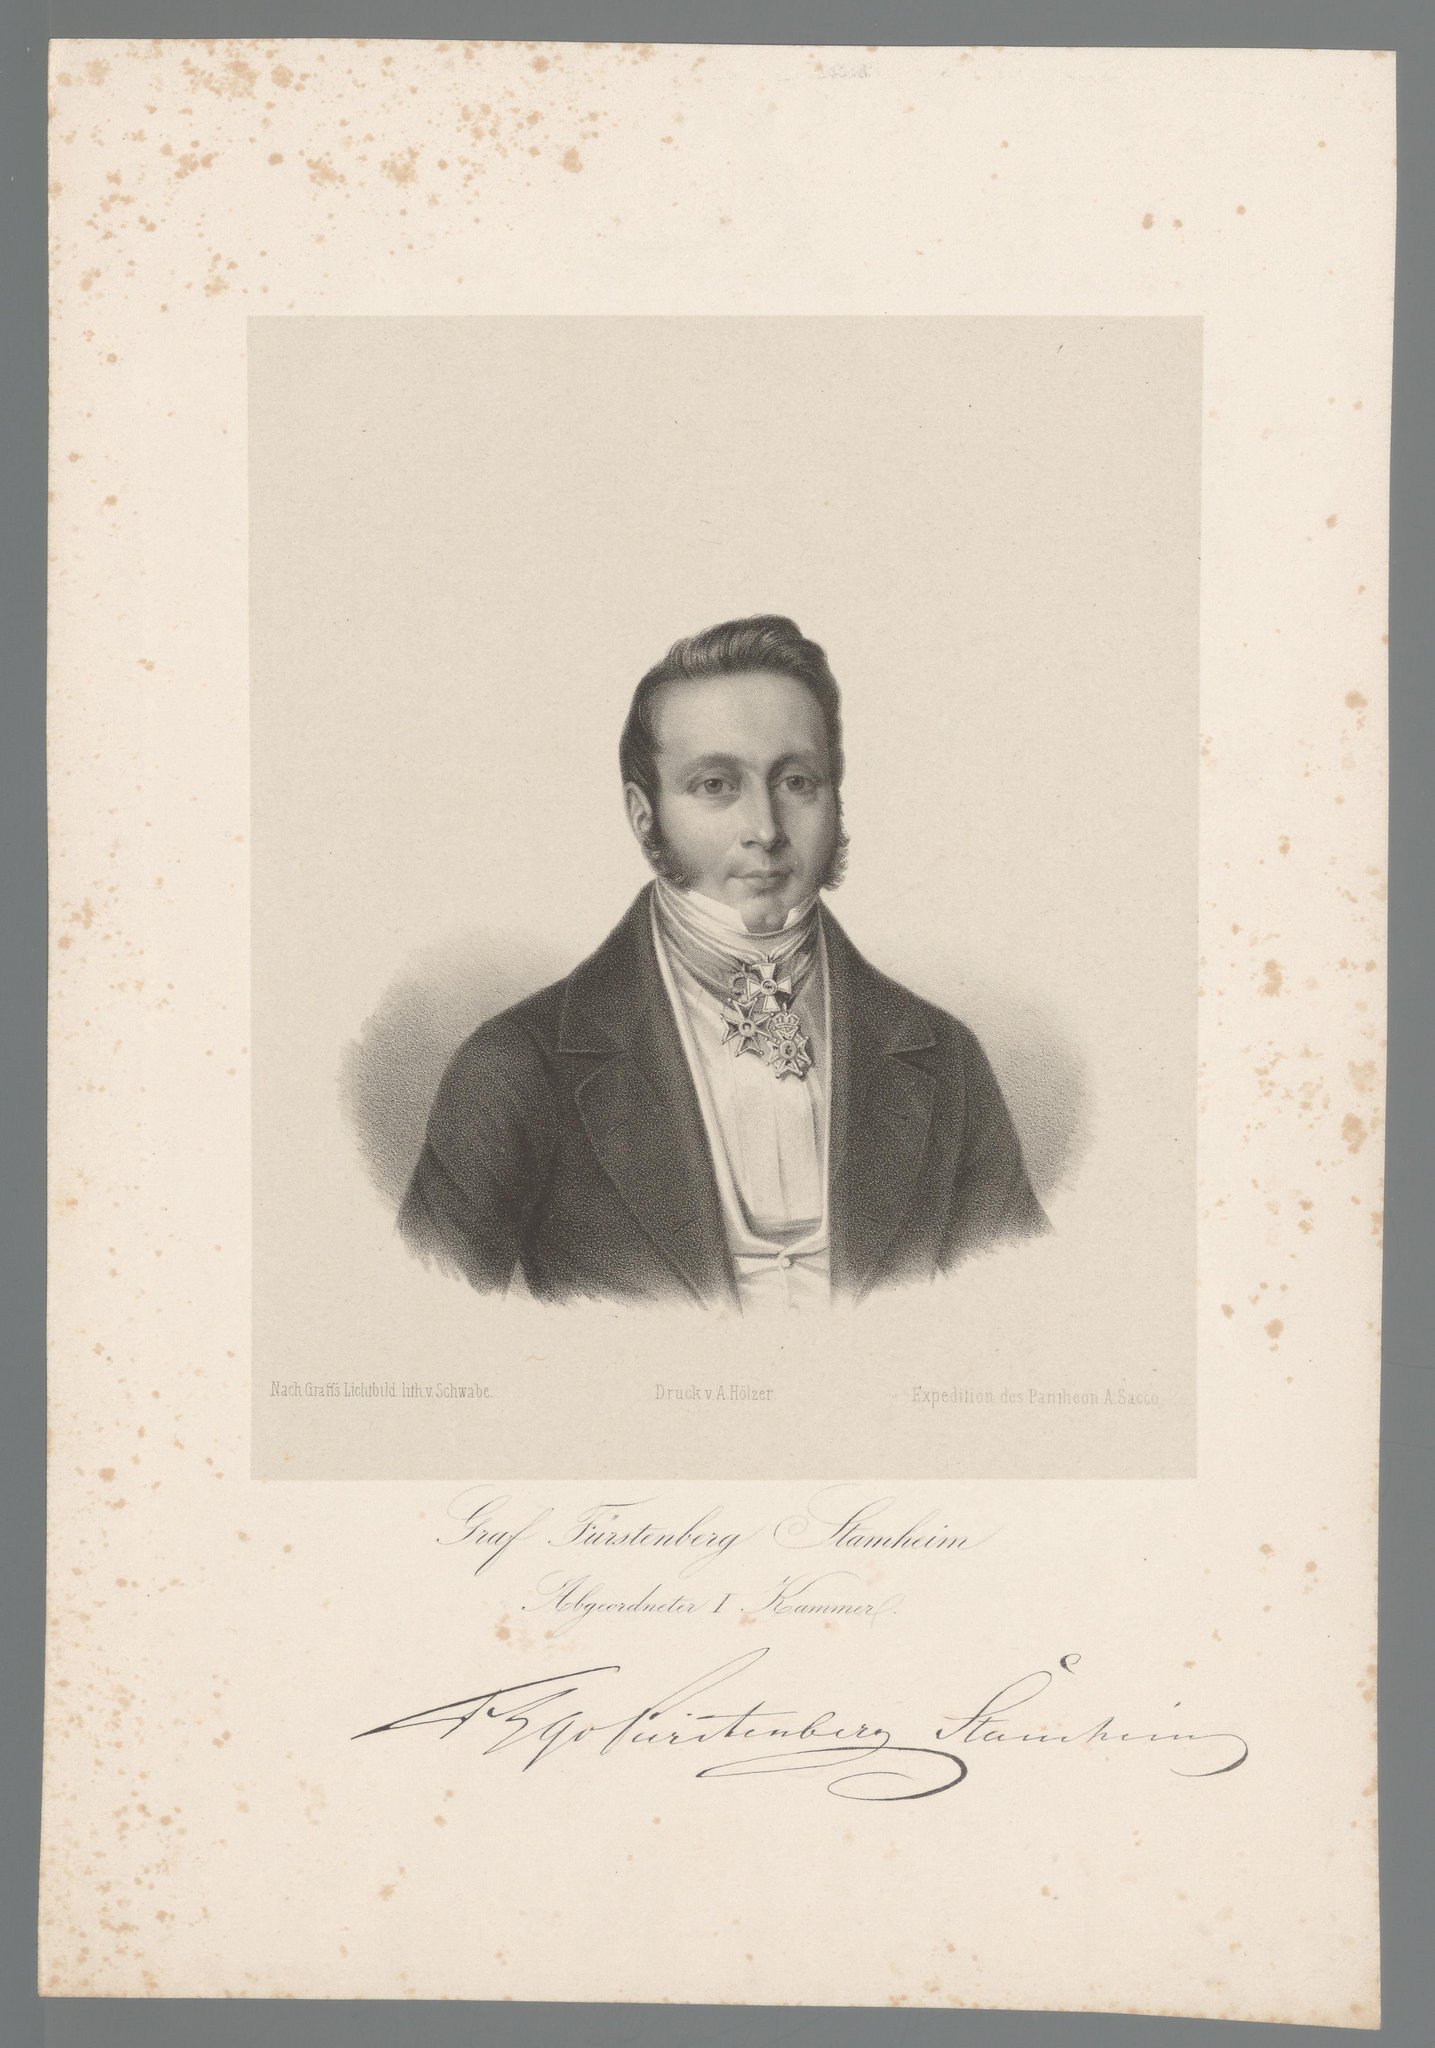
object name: print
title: Pantheon-expeditie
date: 1830-1860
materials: paper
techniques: lithograph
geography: berlin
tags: adult man, historical persons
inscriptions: collector's mark: Lugt 2228